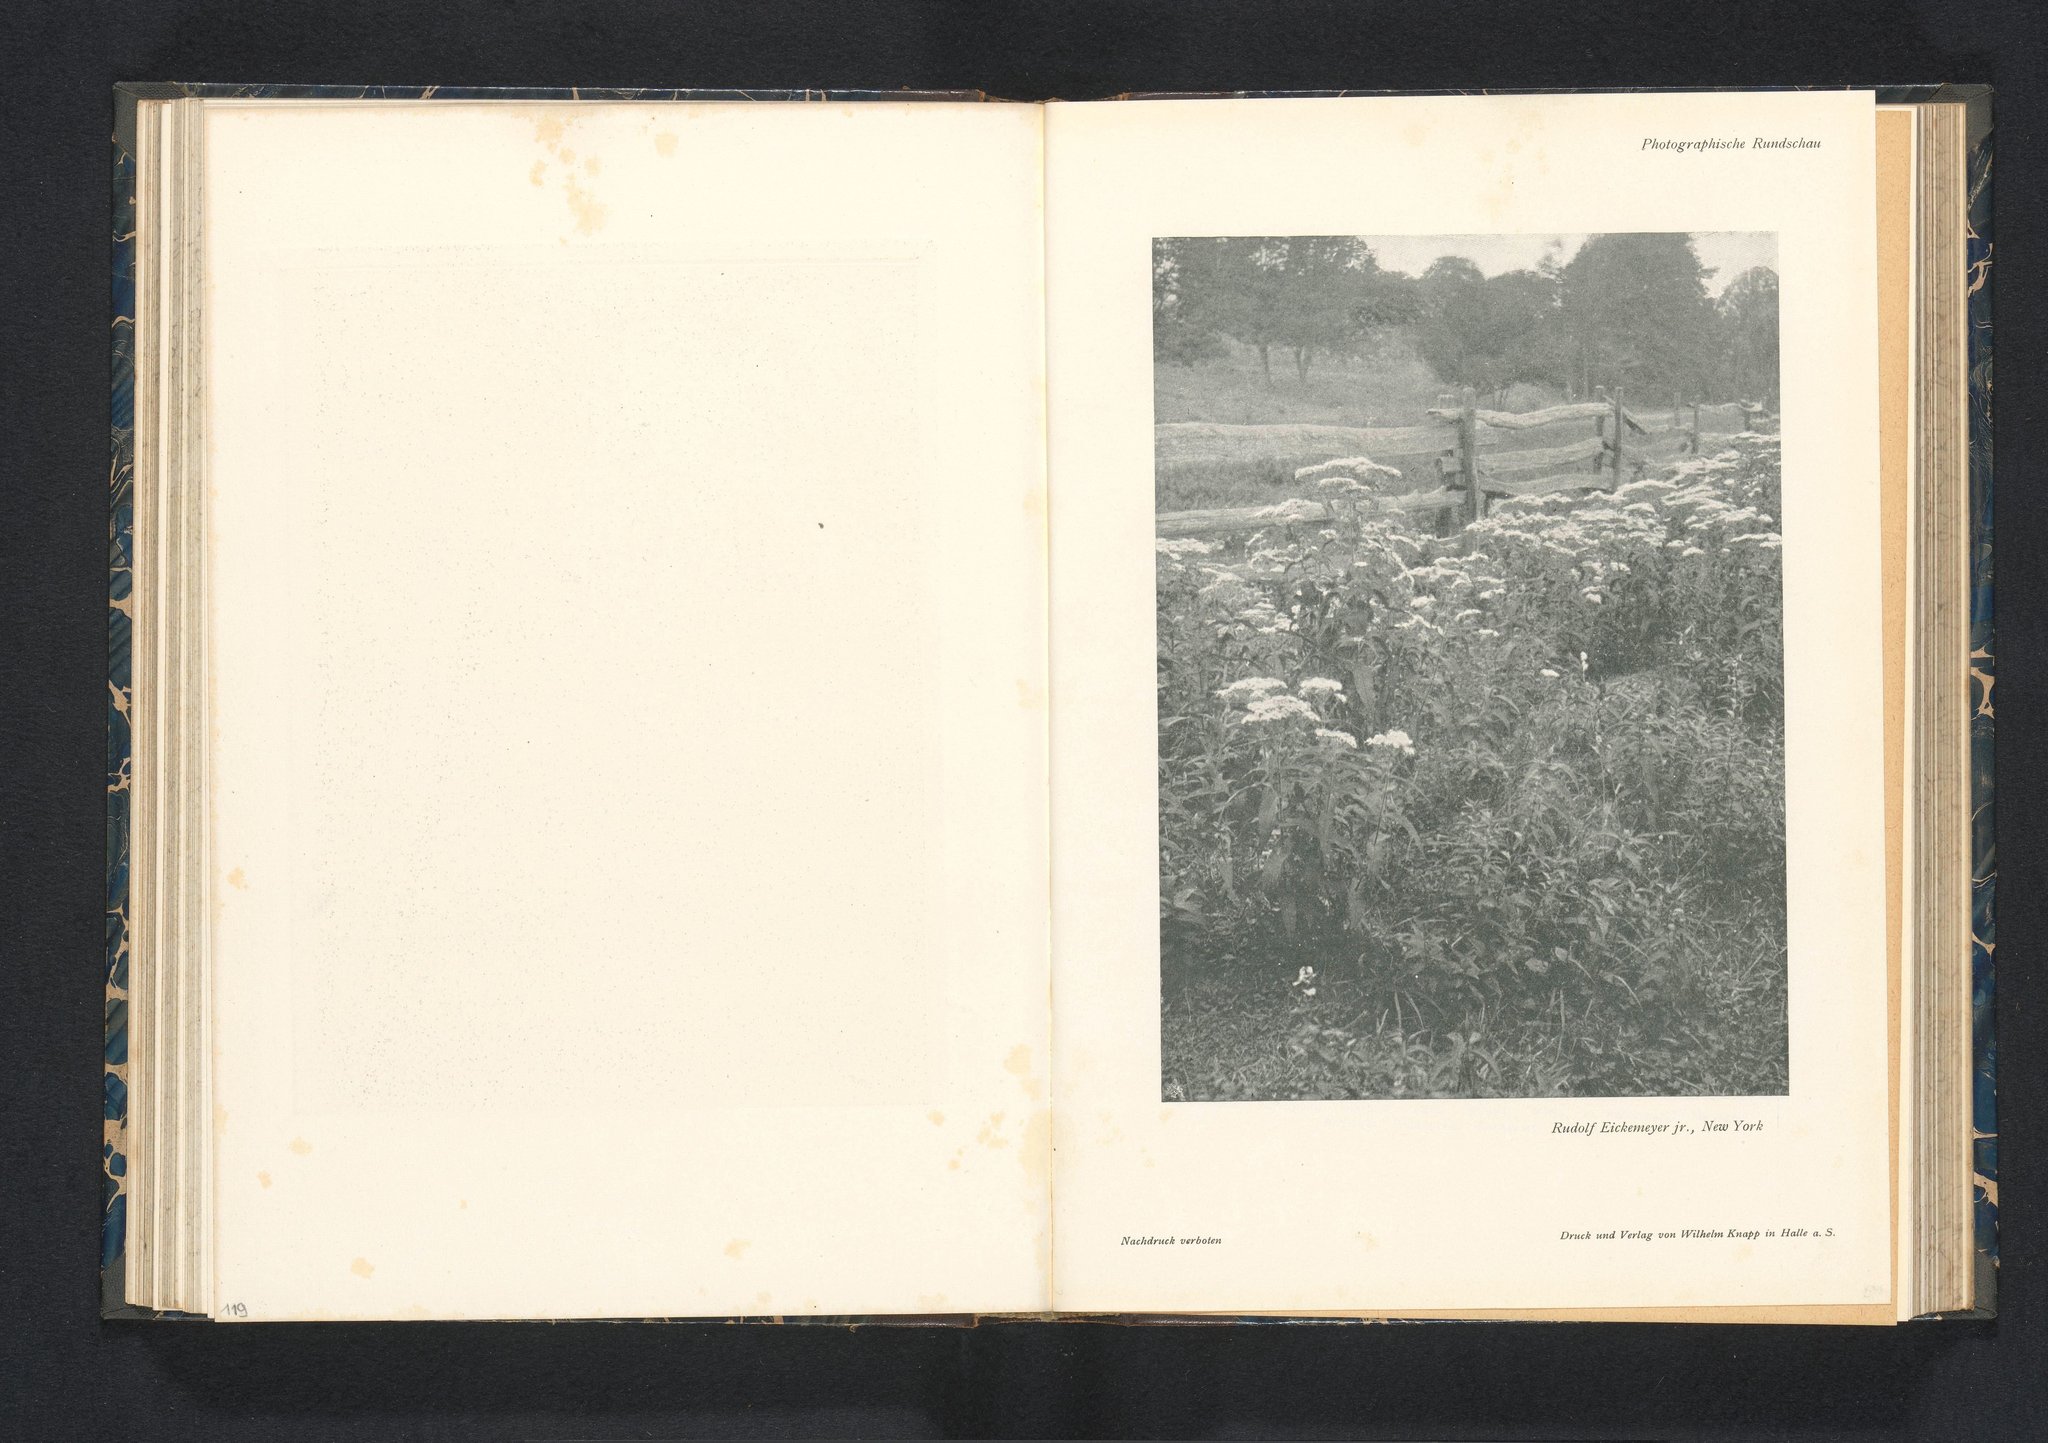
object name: photomechanical print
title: Gezicht op een weide met een hek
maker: rudolf eickemeyer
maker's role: fotograaf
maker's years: 1862-1932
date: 1896-1901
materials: paper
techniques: autotype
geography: berlin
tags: fence, wall, paling, meadow, pasture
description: Prent op tweede ongenummerde pagina na pagina 152.